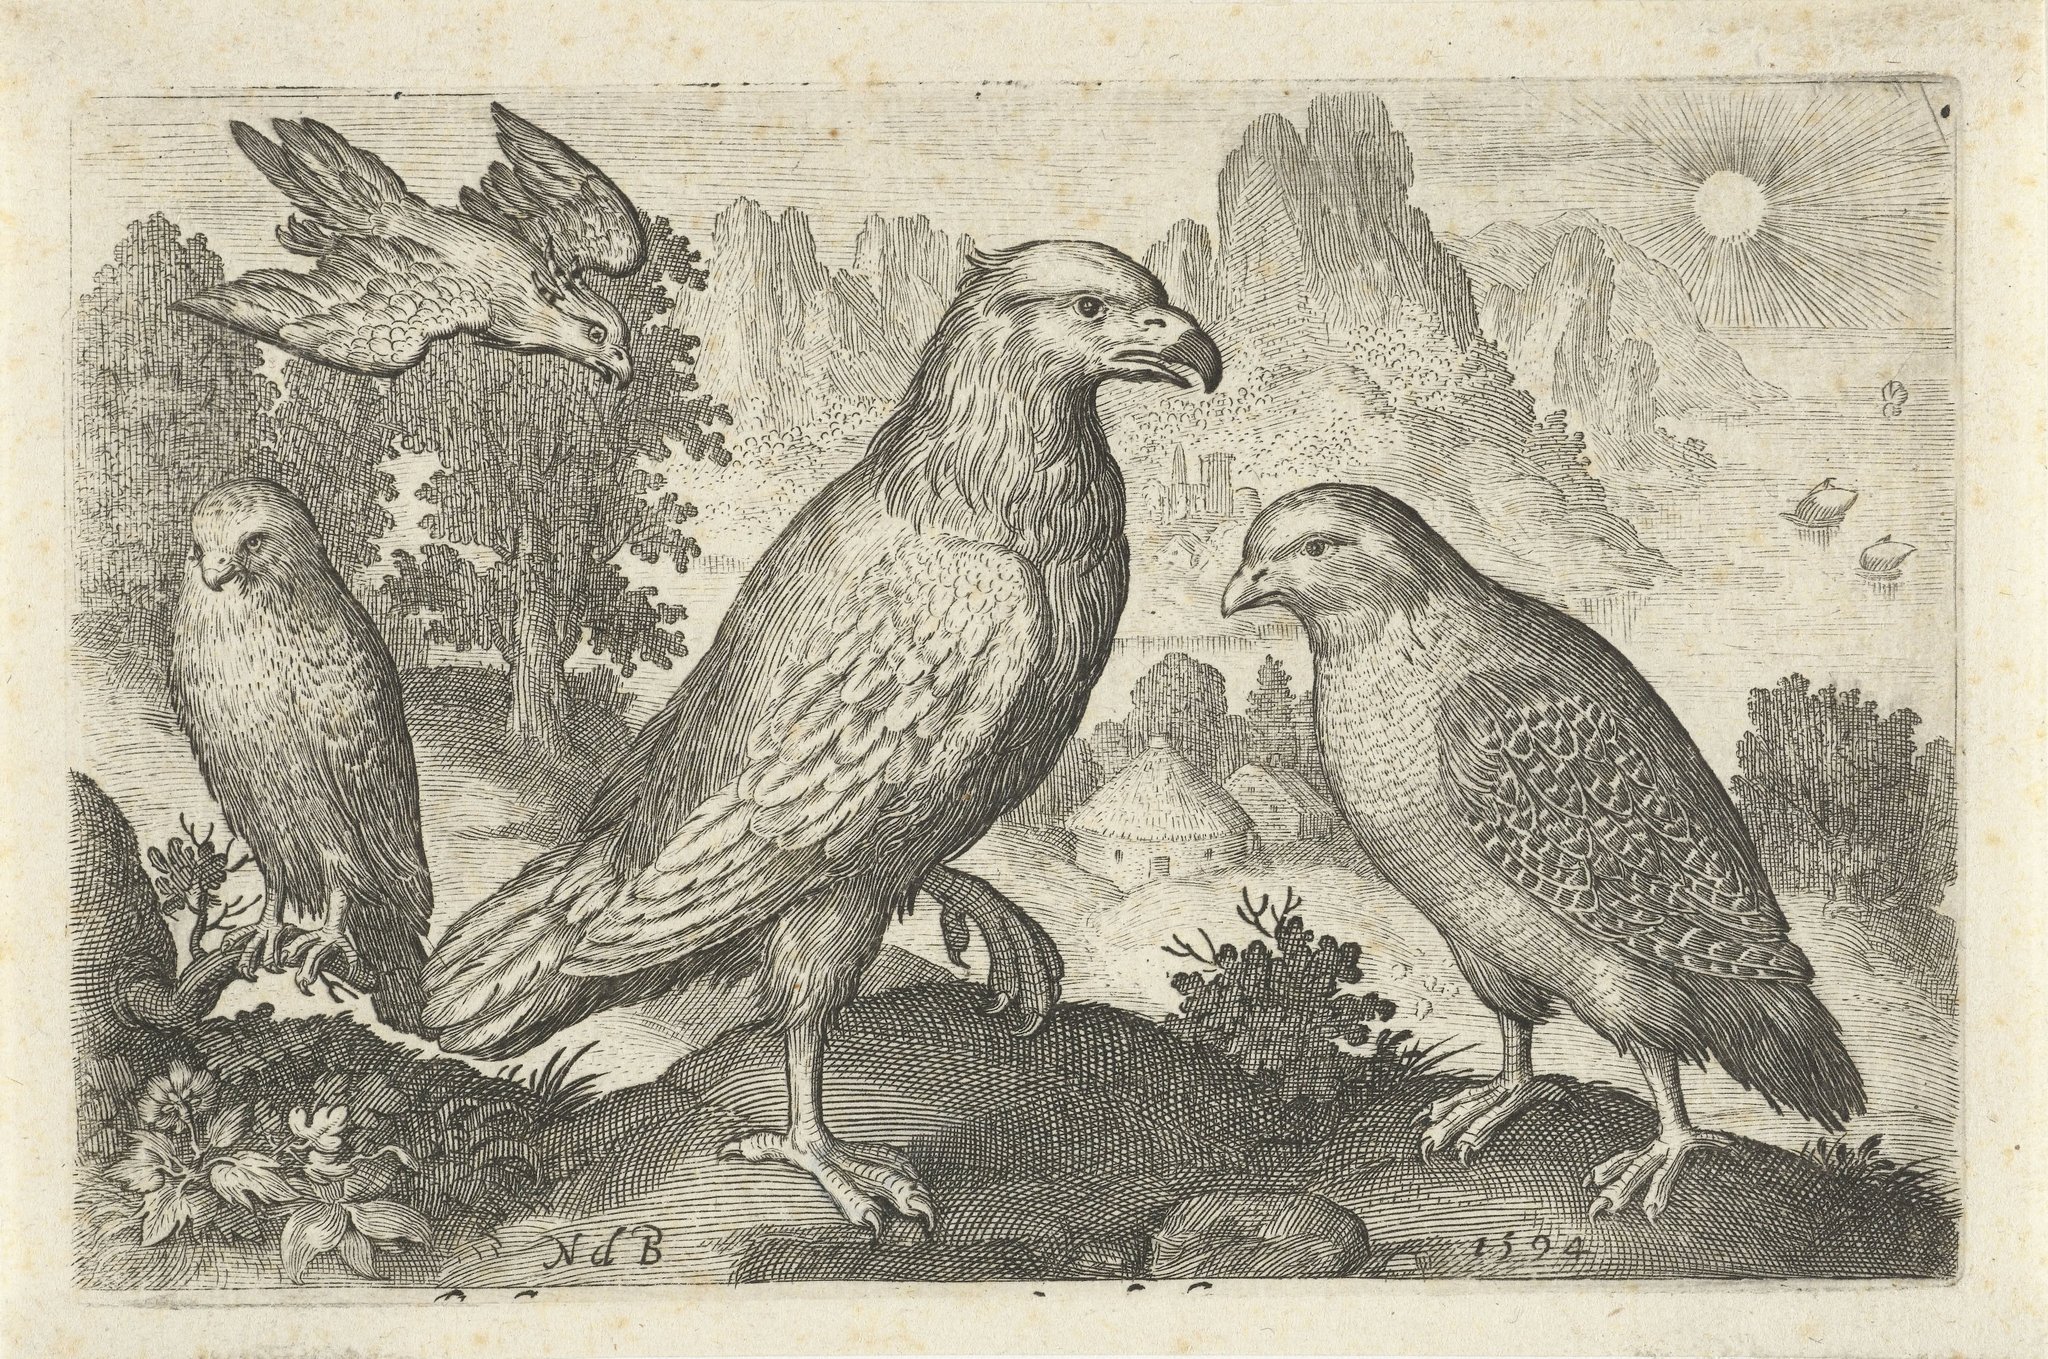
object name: print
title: Arend en andere roofvogels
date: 1594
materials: paper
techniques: engraving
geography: antwerp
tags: predatory birds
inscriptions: collector's mark: Lugt 2228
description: Prent uit serie van twaalf prenten met vogels en insecten. Bij Hollstein zijn bladen van een andere serie prenten afgebeeld, zie De Groot 1988, p. 37.